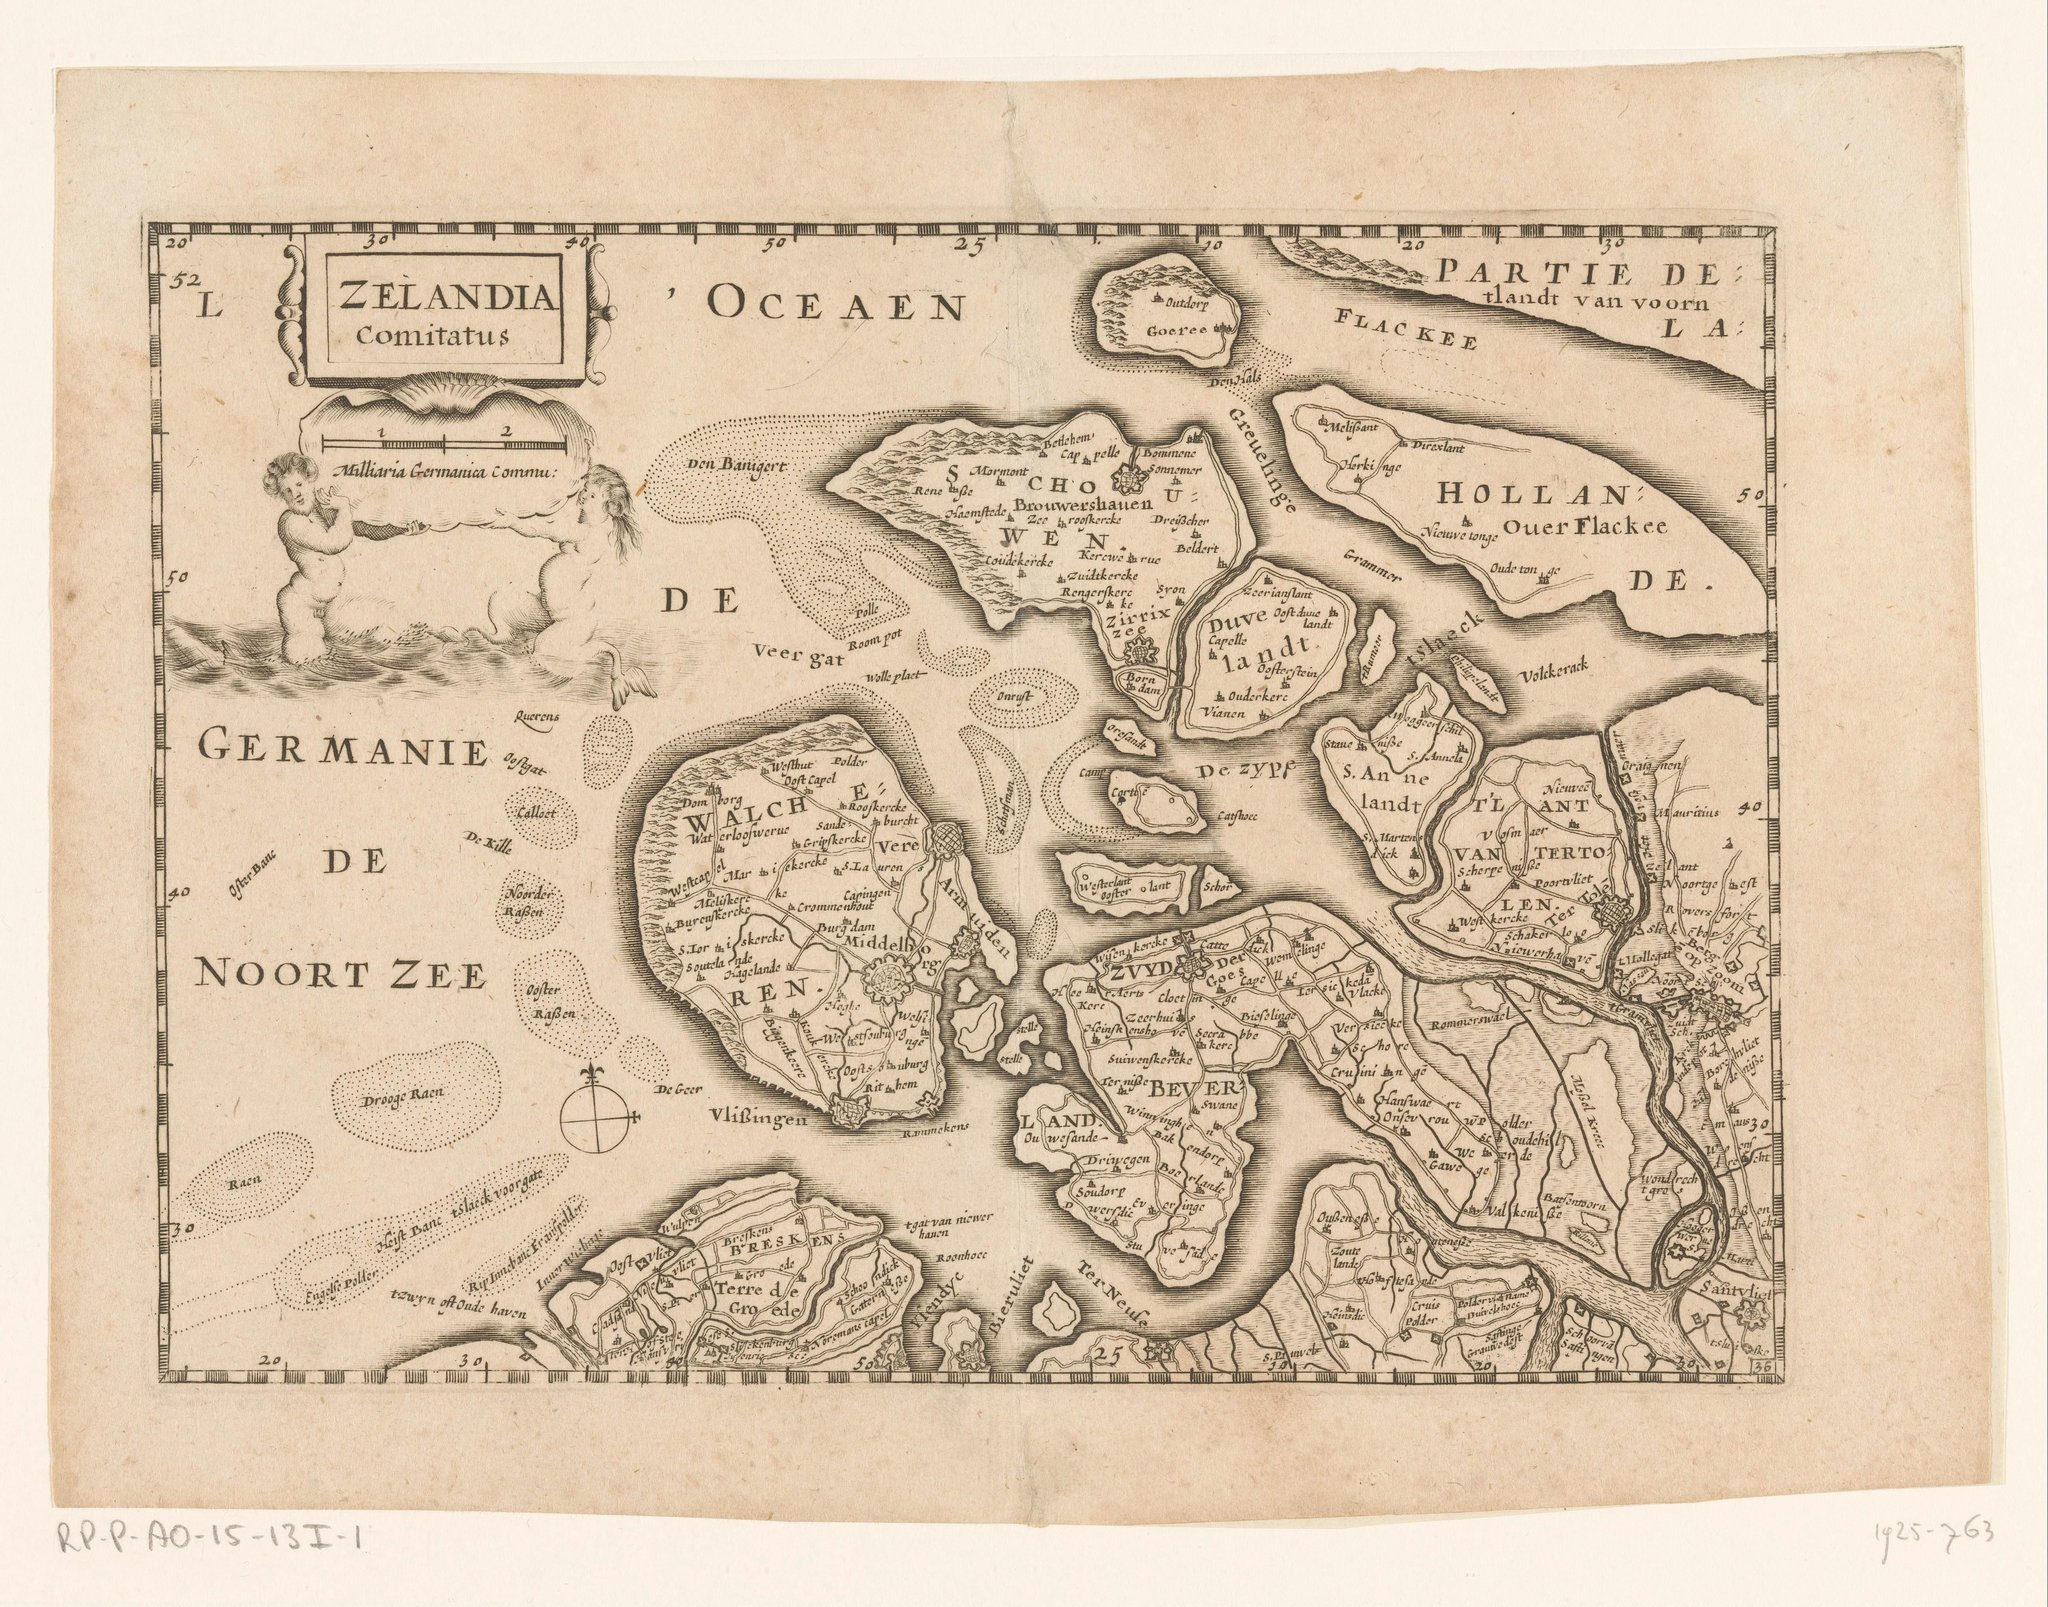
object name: map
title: Zelandia Comitatus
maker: Anonymous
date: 1635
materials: paper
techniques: engraving, etching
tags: maps of separate countries or regions, zeeland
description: Deze staat van prent ook gebruikt in: De vyerighe colom klaer vertoonende in vyftich onderscheydene curieuse caarten de XVII. Nederlantsche Provincien (…). Amsterdam: Jacob Aertsz Colom (I), s.a. [ca. 1660]. En in latere uitgaven met de platen van deze publicatie, uitgegeven door Pieter van Alphen (1691) en Pieter van der Slaart (1696). Zie documentatie voor meer informatie. Eerdere staat van prent (zonder ‘36’ rechtsonder) ook gebruikt in eerdere drukken van deze publicatie.